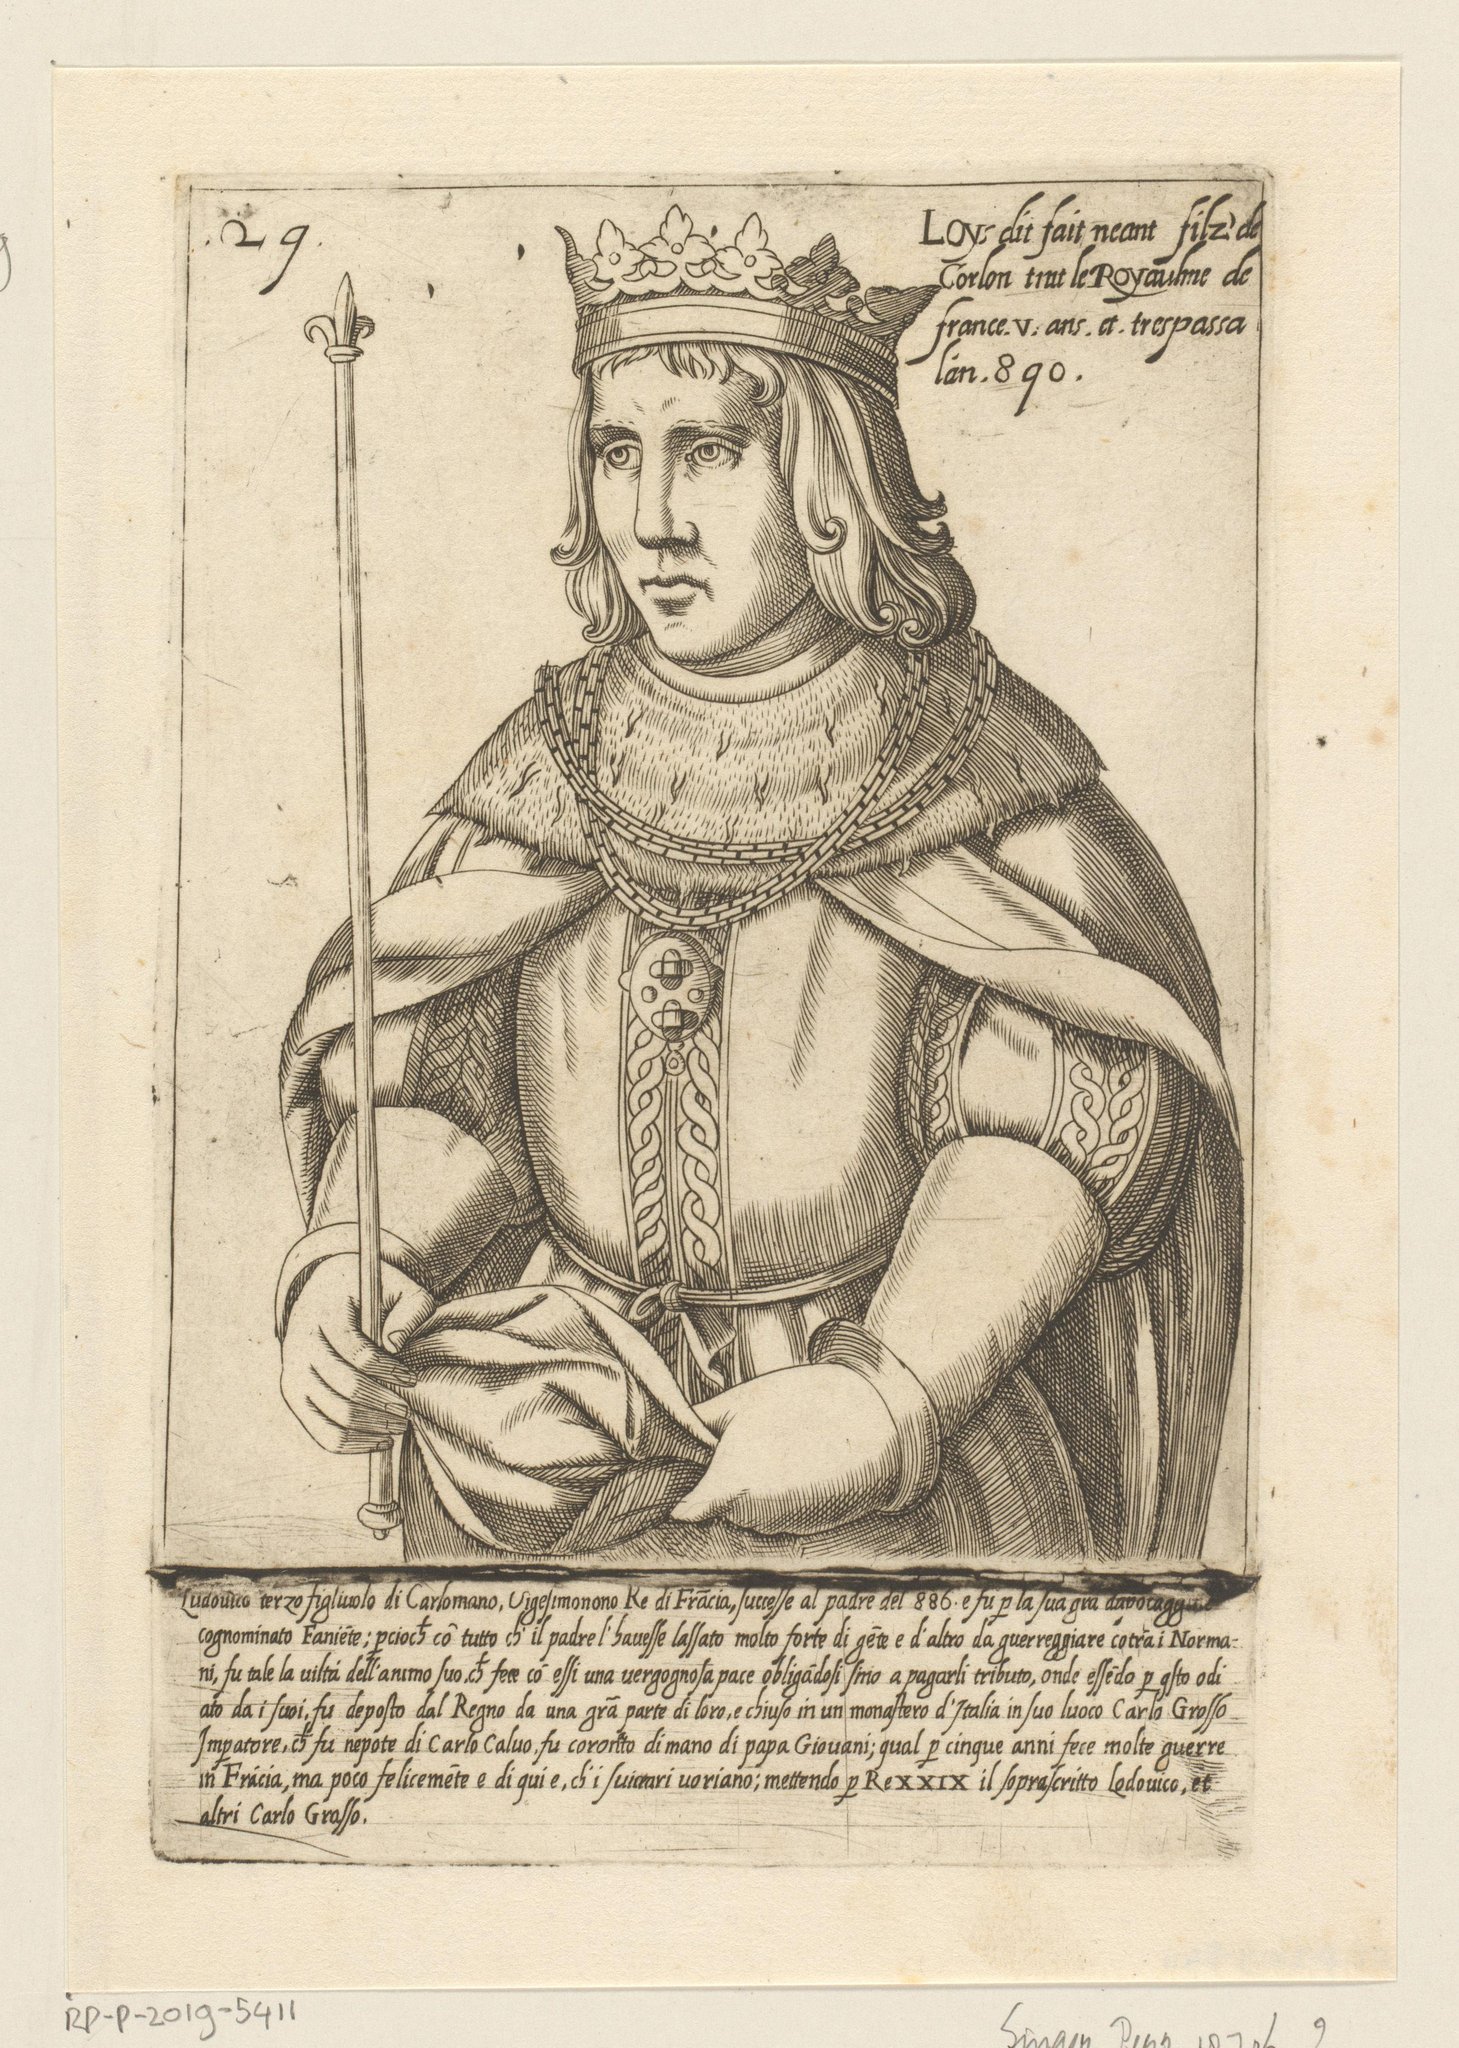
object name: print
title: Portret van Lodewijk III, koning van West-Francië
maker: Anonymous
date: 1588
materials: paper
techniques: engraving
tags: crown (symbol of sovereignty), sceptre, staff (symbol of sovereignty), historical persons, king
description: Prent voor het eerst gebruikt in: Cronica Breve de i fatti illustri de're di Francia, con le loro effigie dal naturale cominciando da Faramondo (...). Venetië: Bernardo Giunti, 1588. Prent in ieder geval ook gebruikt in de editie van 1590 en mogelijk ook in een Franse uitgave van 1597.